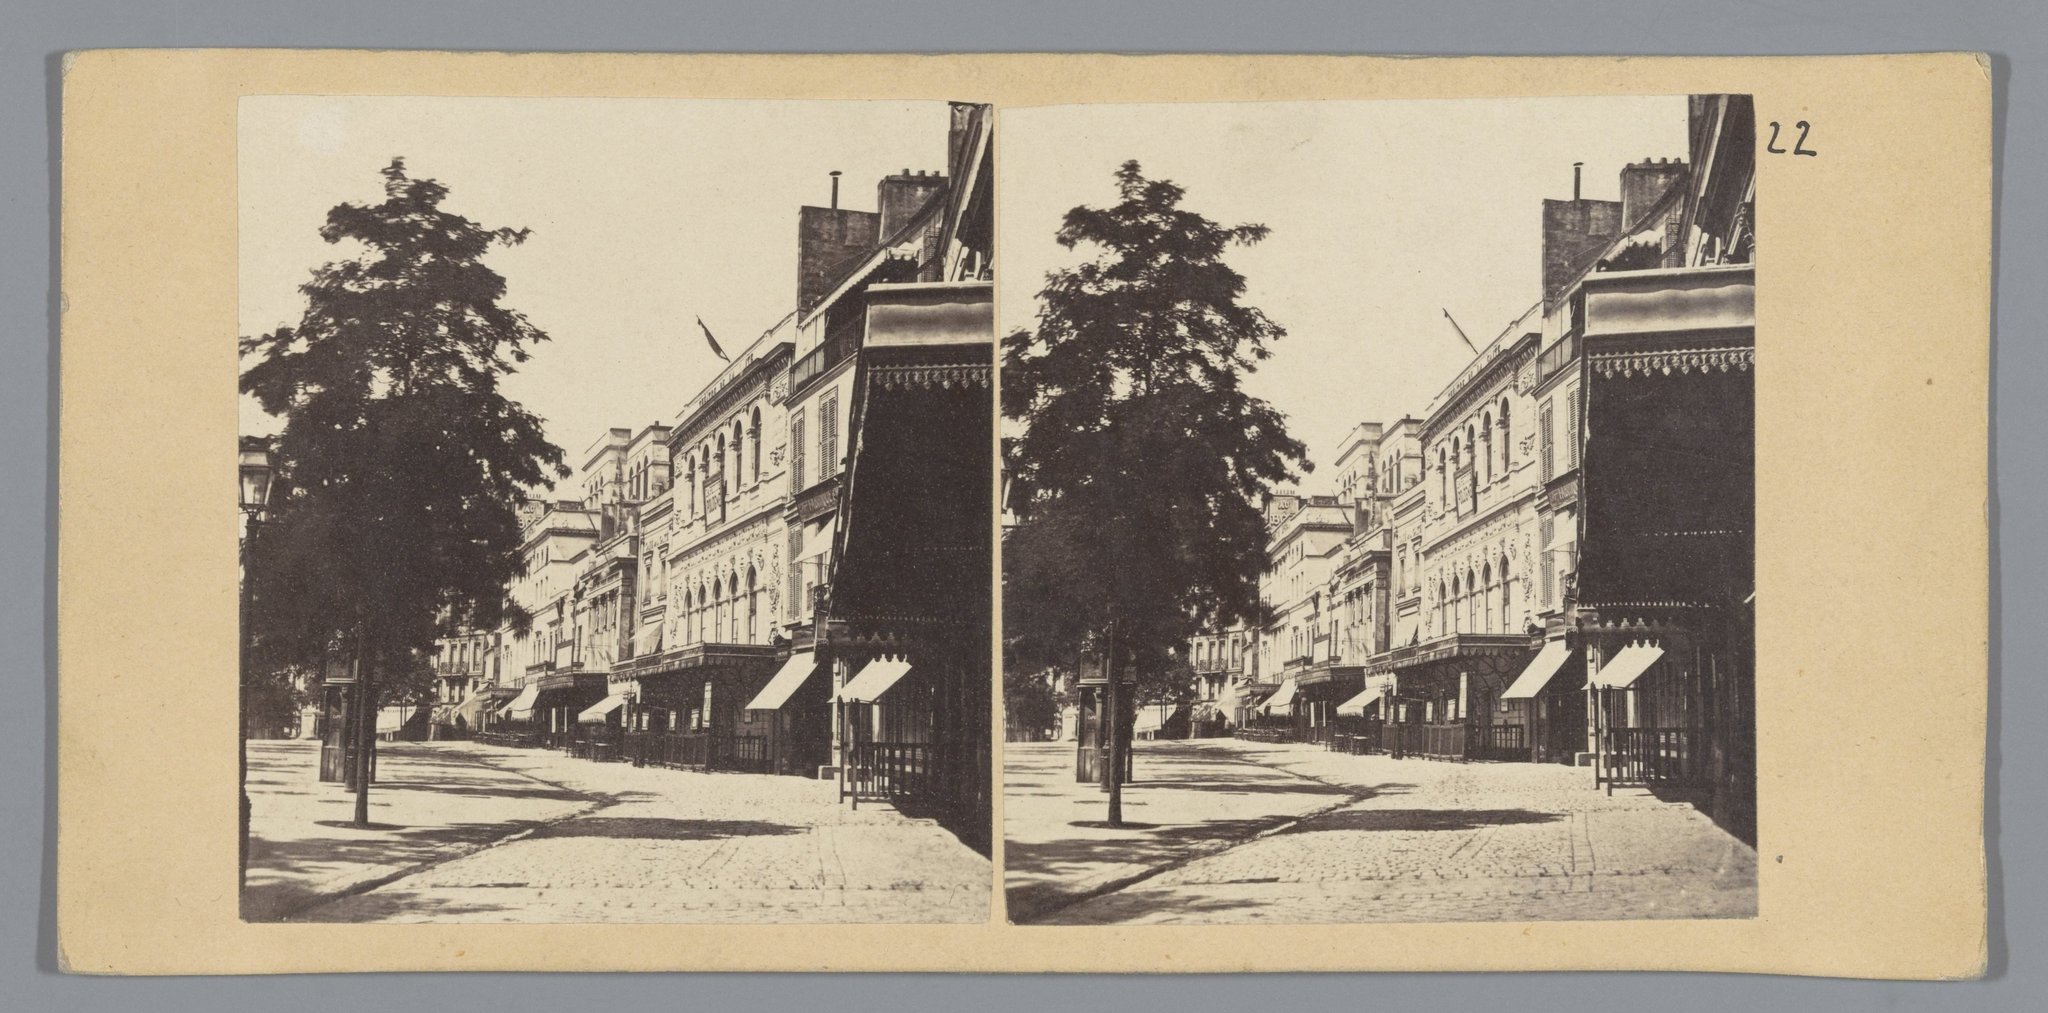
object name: stereograph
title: Gezicht op de Boulevard du Temple, Parijs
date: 1851-1880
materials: cardboard, paper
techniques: albumen print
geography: paris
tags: avenue, boulevard, promenade, esplanade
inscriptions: number: ‘22’, retailer's mark: ‘222, rue de Rivoli/ en face le Jardin des Tuileries./ Lecocq-Frêne/ Estampes Photographies/ Plans et Guides pour Voyageurs/ Vues pr Stéreoscopes.’